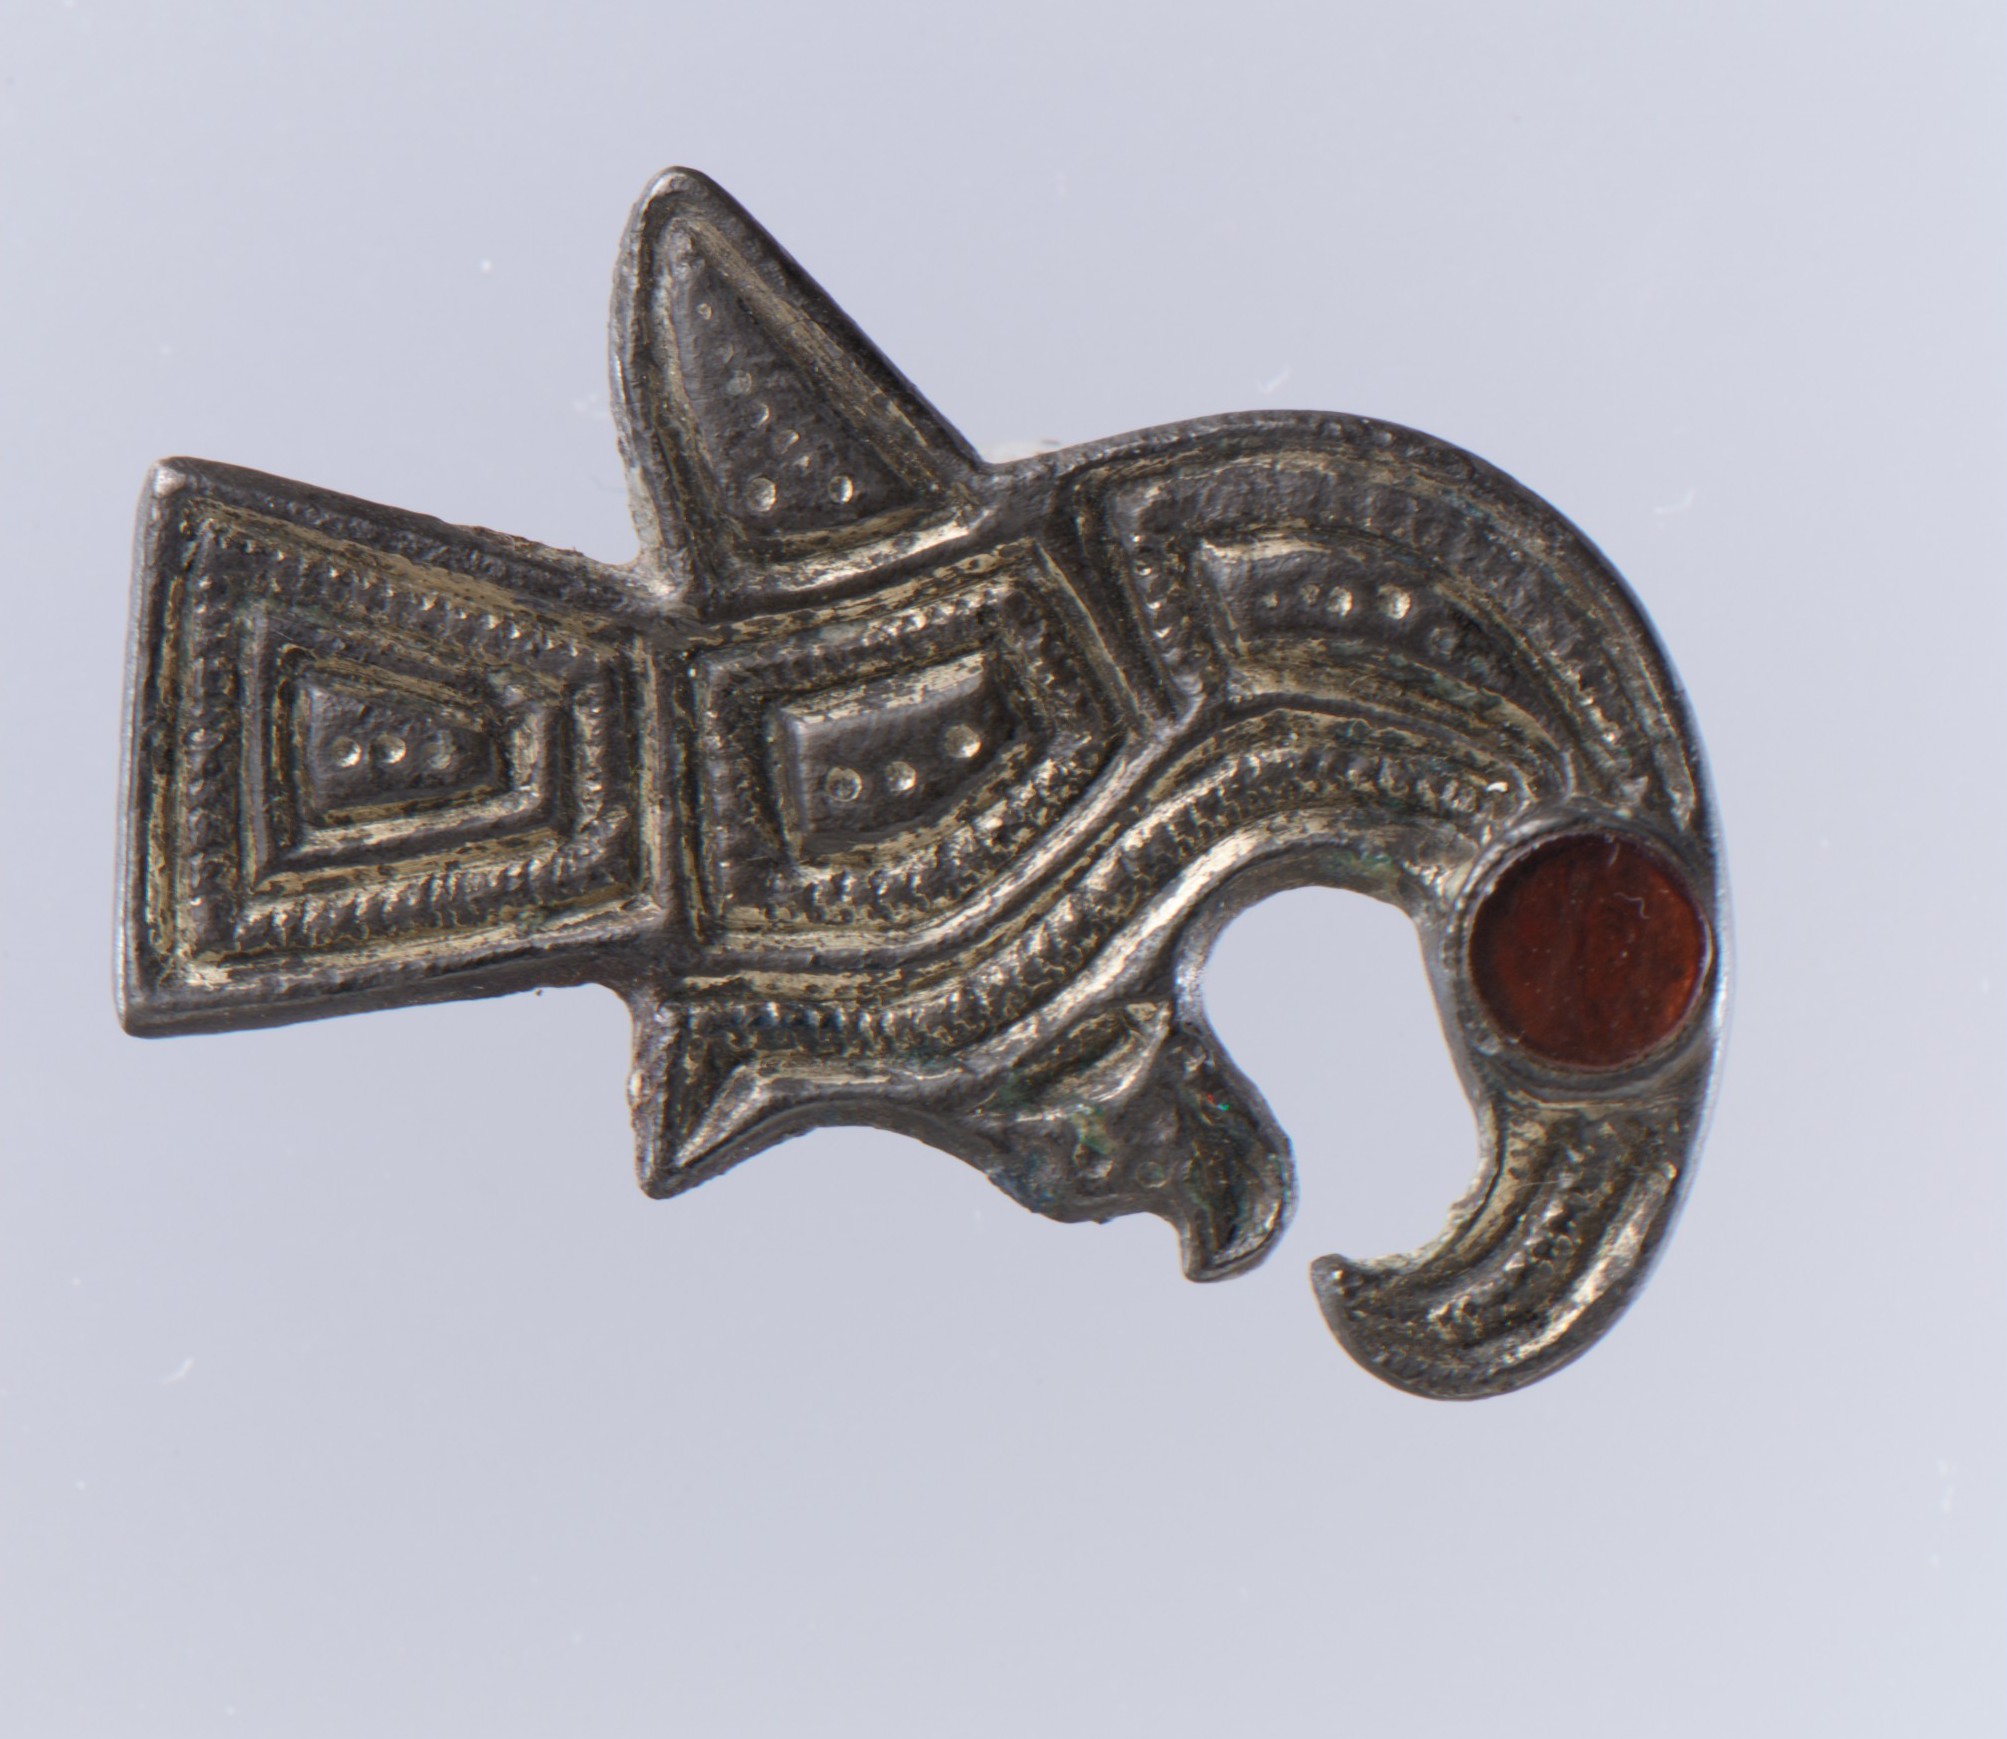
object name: brooch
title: Bird-Shaped Brooch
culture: frankish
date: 550-600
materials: foil, gemstone, silver gilt